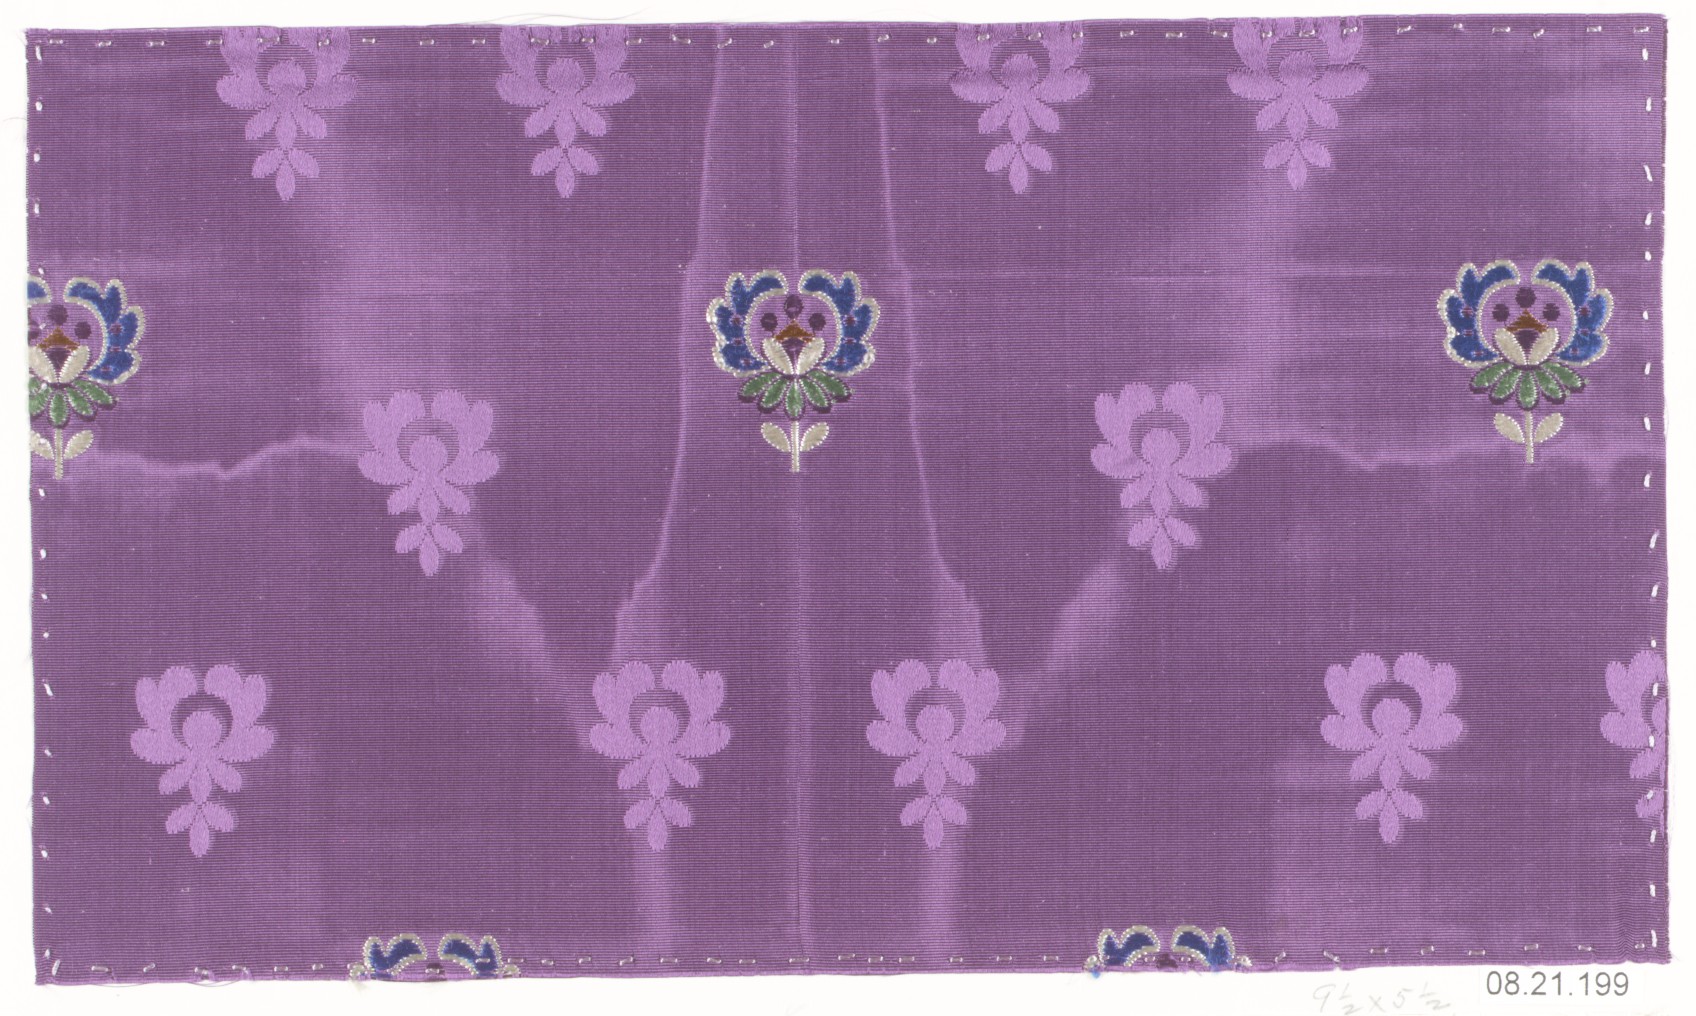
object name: textile sample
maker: Anonymous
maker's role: designer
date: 1900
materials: silk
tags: flowers